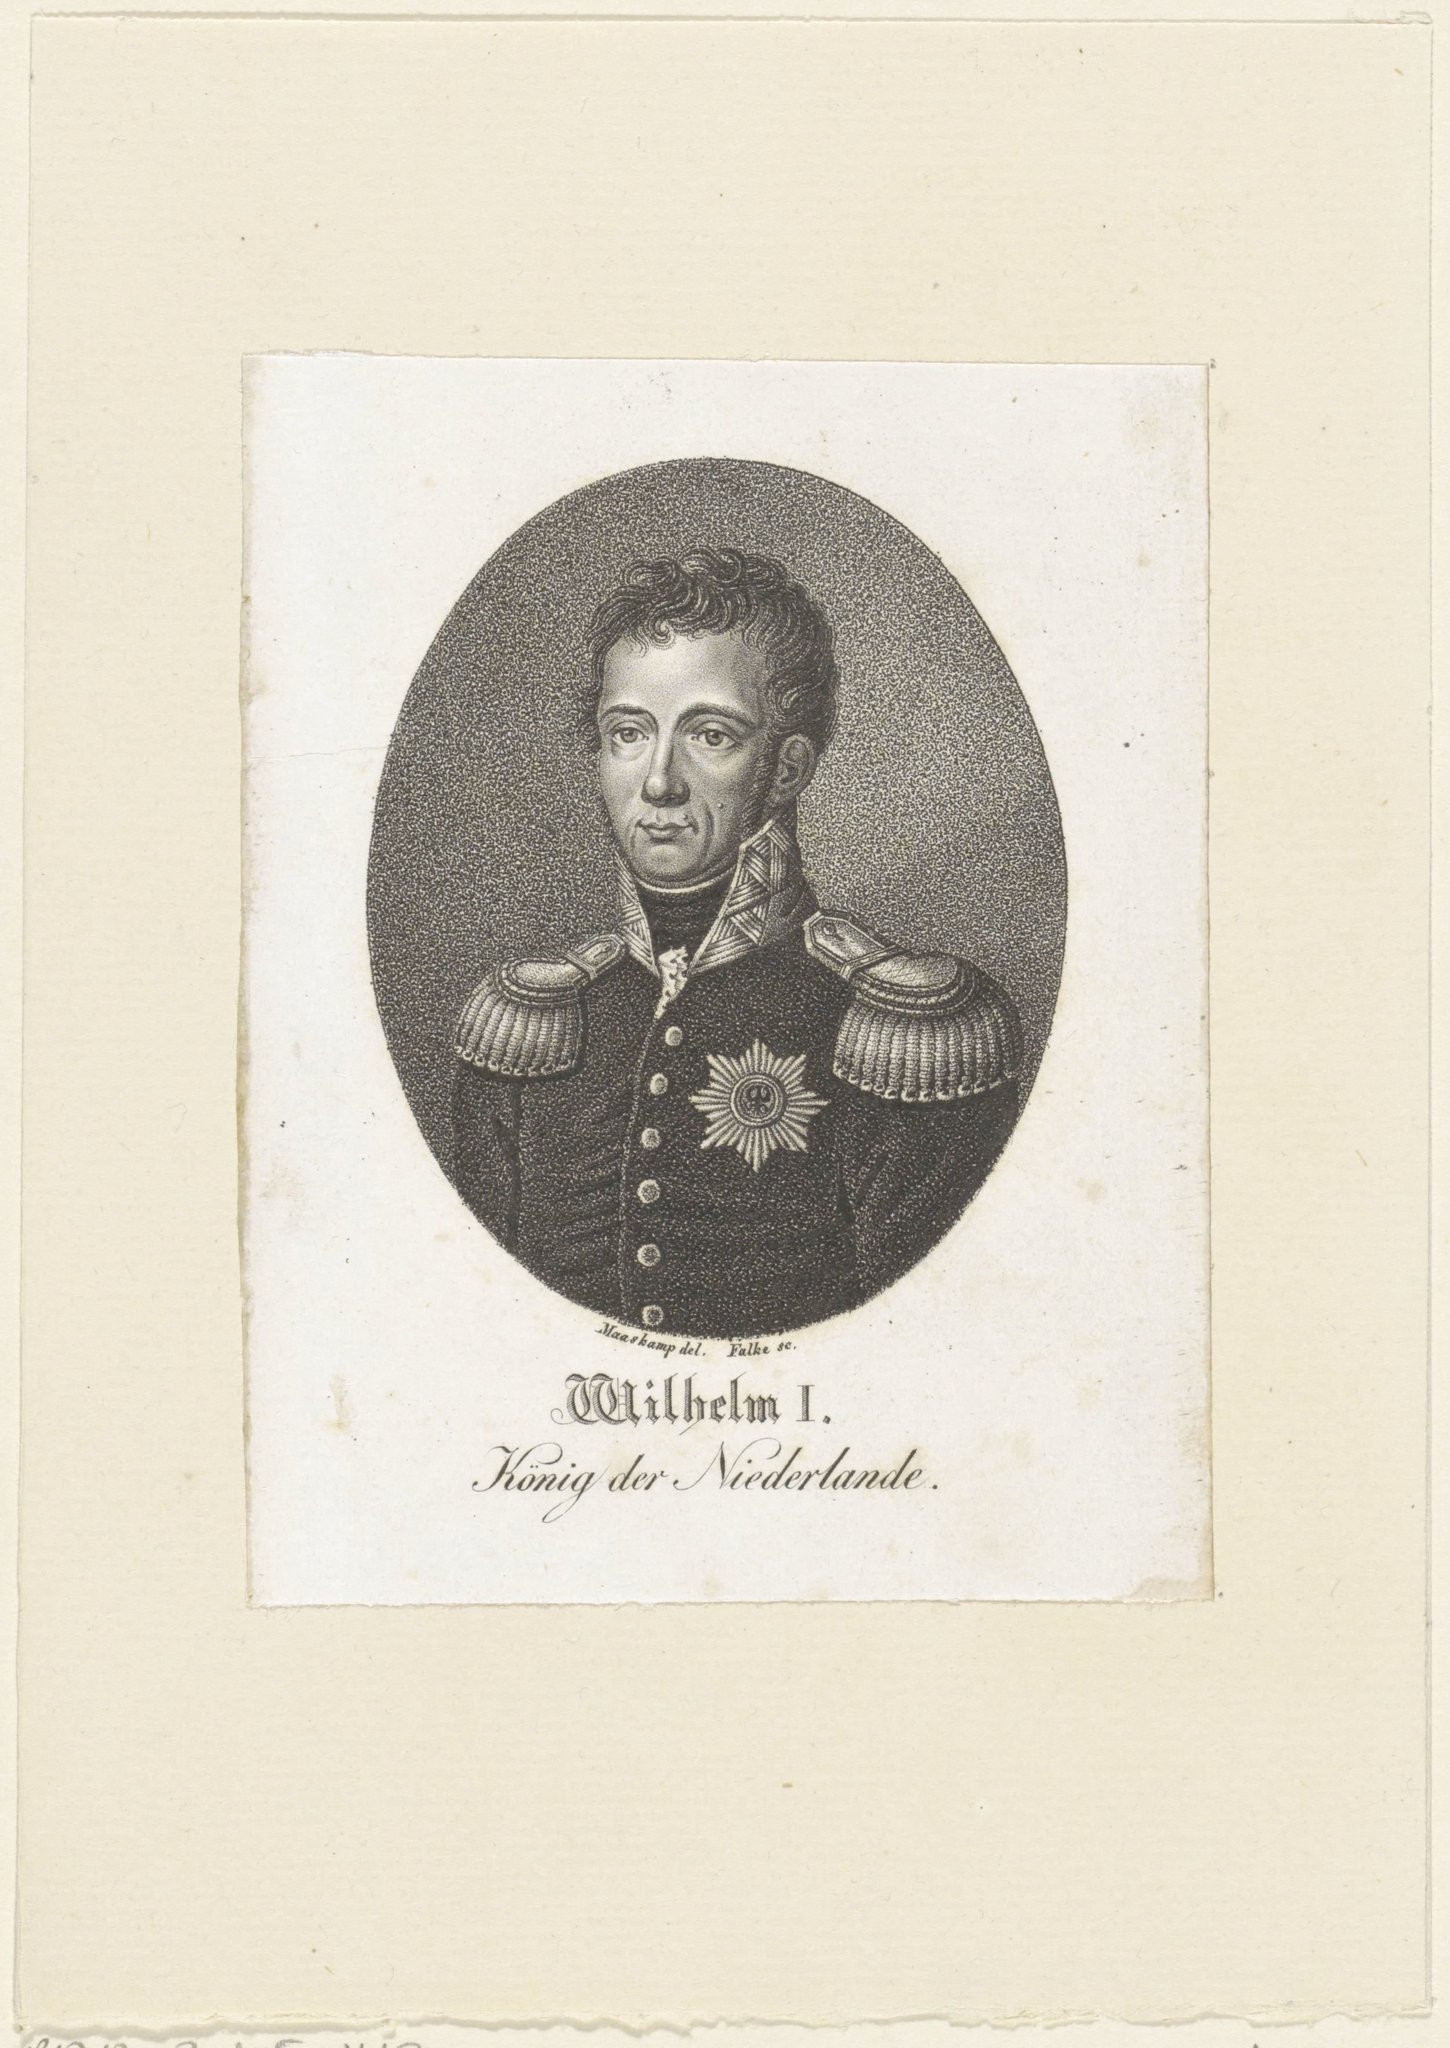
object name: print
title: Portret van Willem I Frederik, koning der Nederlanden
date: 1813-1899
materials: paper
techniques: engraving, etching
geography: germany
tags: the hague, berlin, william i of the netherlands, knighthood order (with name) - insignia of a knighthood order, e.g.: badge, chain (with name of order)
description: De hier vermelde titel verwijst naar de hoogst verkregen titel van de geportretteerde, niet per se naar de titel die de geportretteerde op deze voorstelling draagt.